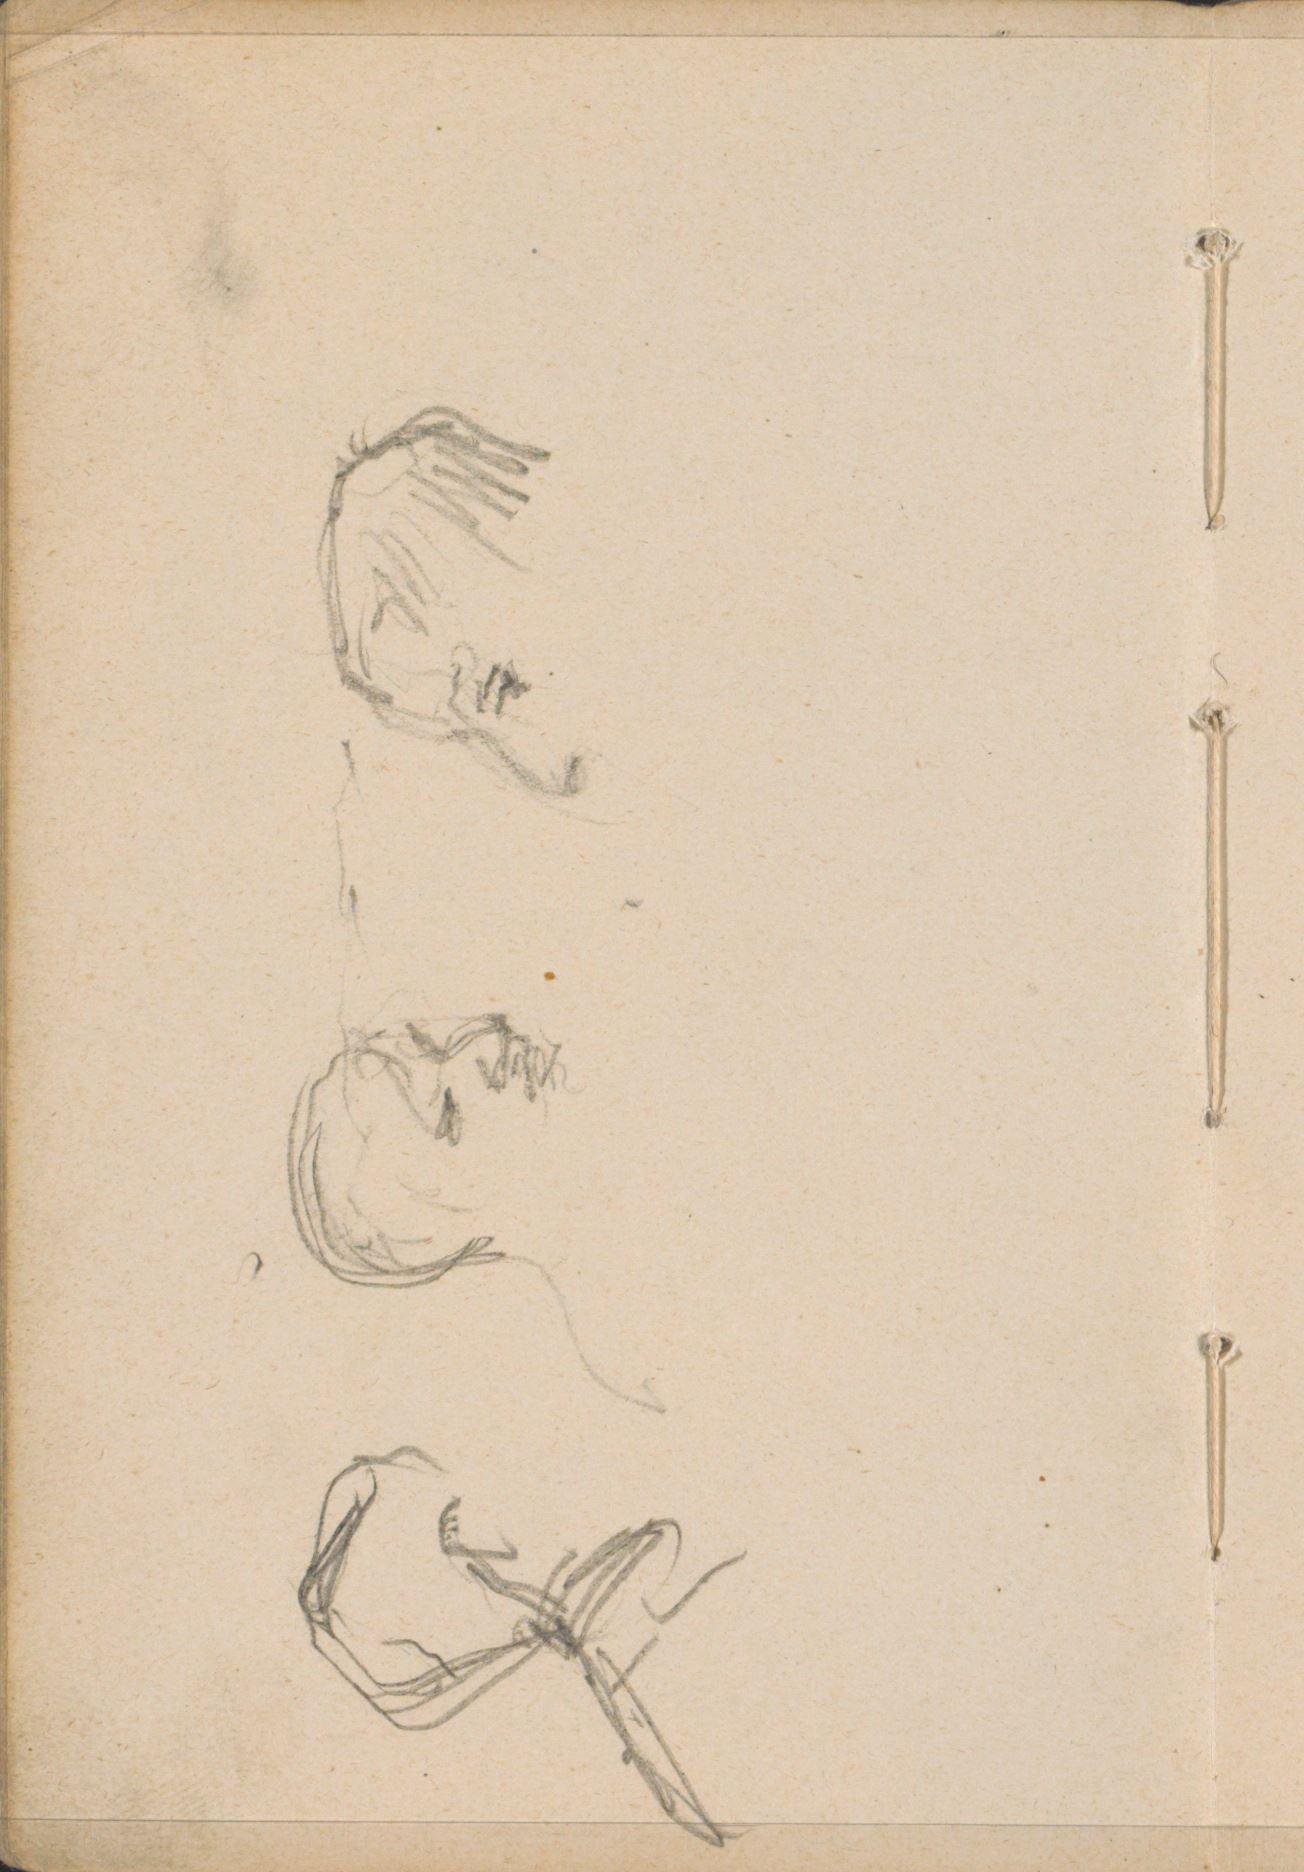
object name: sketchbook leaf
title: Studieblad met mannenhoofden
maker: george hendrik breitner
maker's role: draughtsman, painter, print maker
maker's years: 1857-1923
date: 1903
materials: paper, pencil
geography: amsterdam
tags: head (human)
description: Studieblad met mannenhoofden. Pagina 11 uit een schetsboek met 46 bladen vervaardigd te Amsterdam en Haarlem.